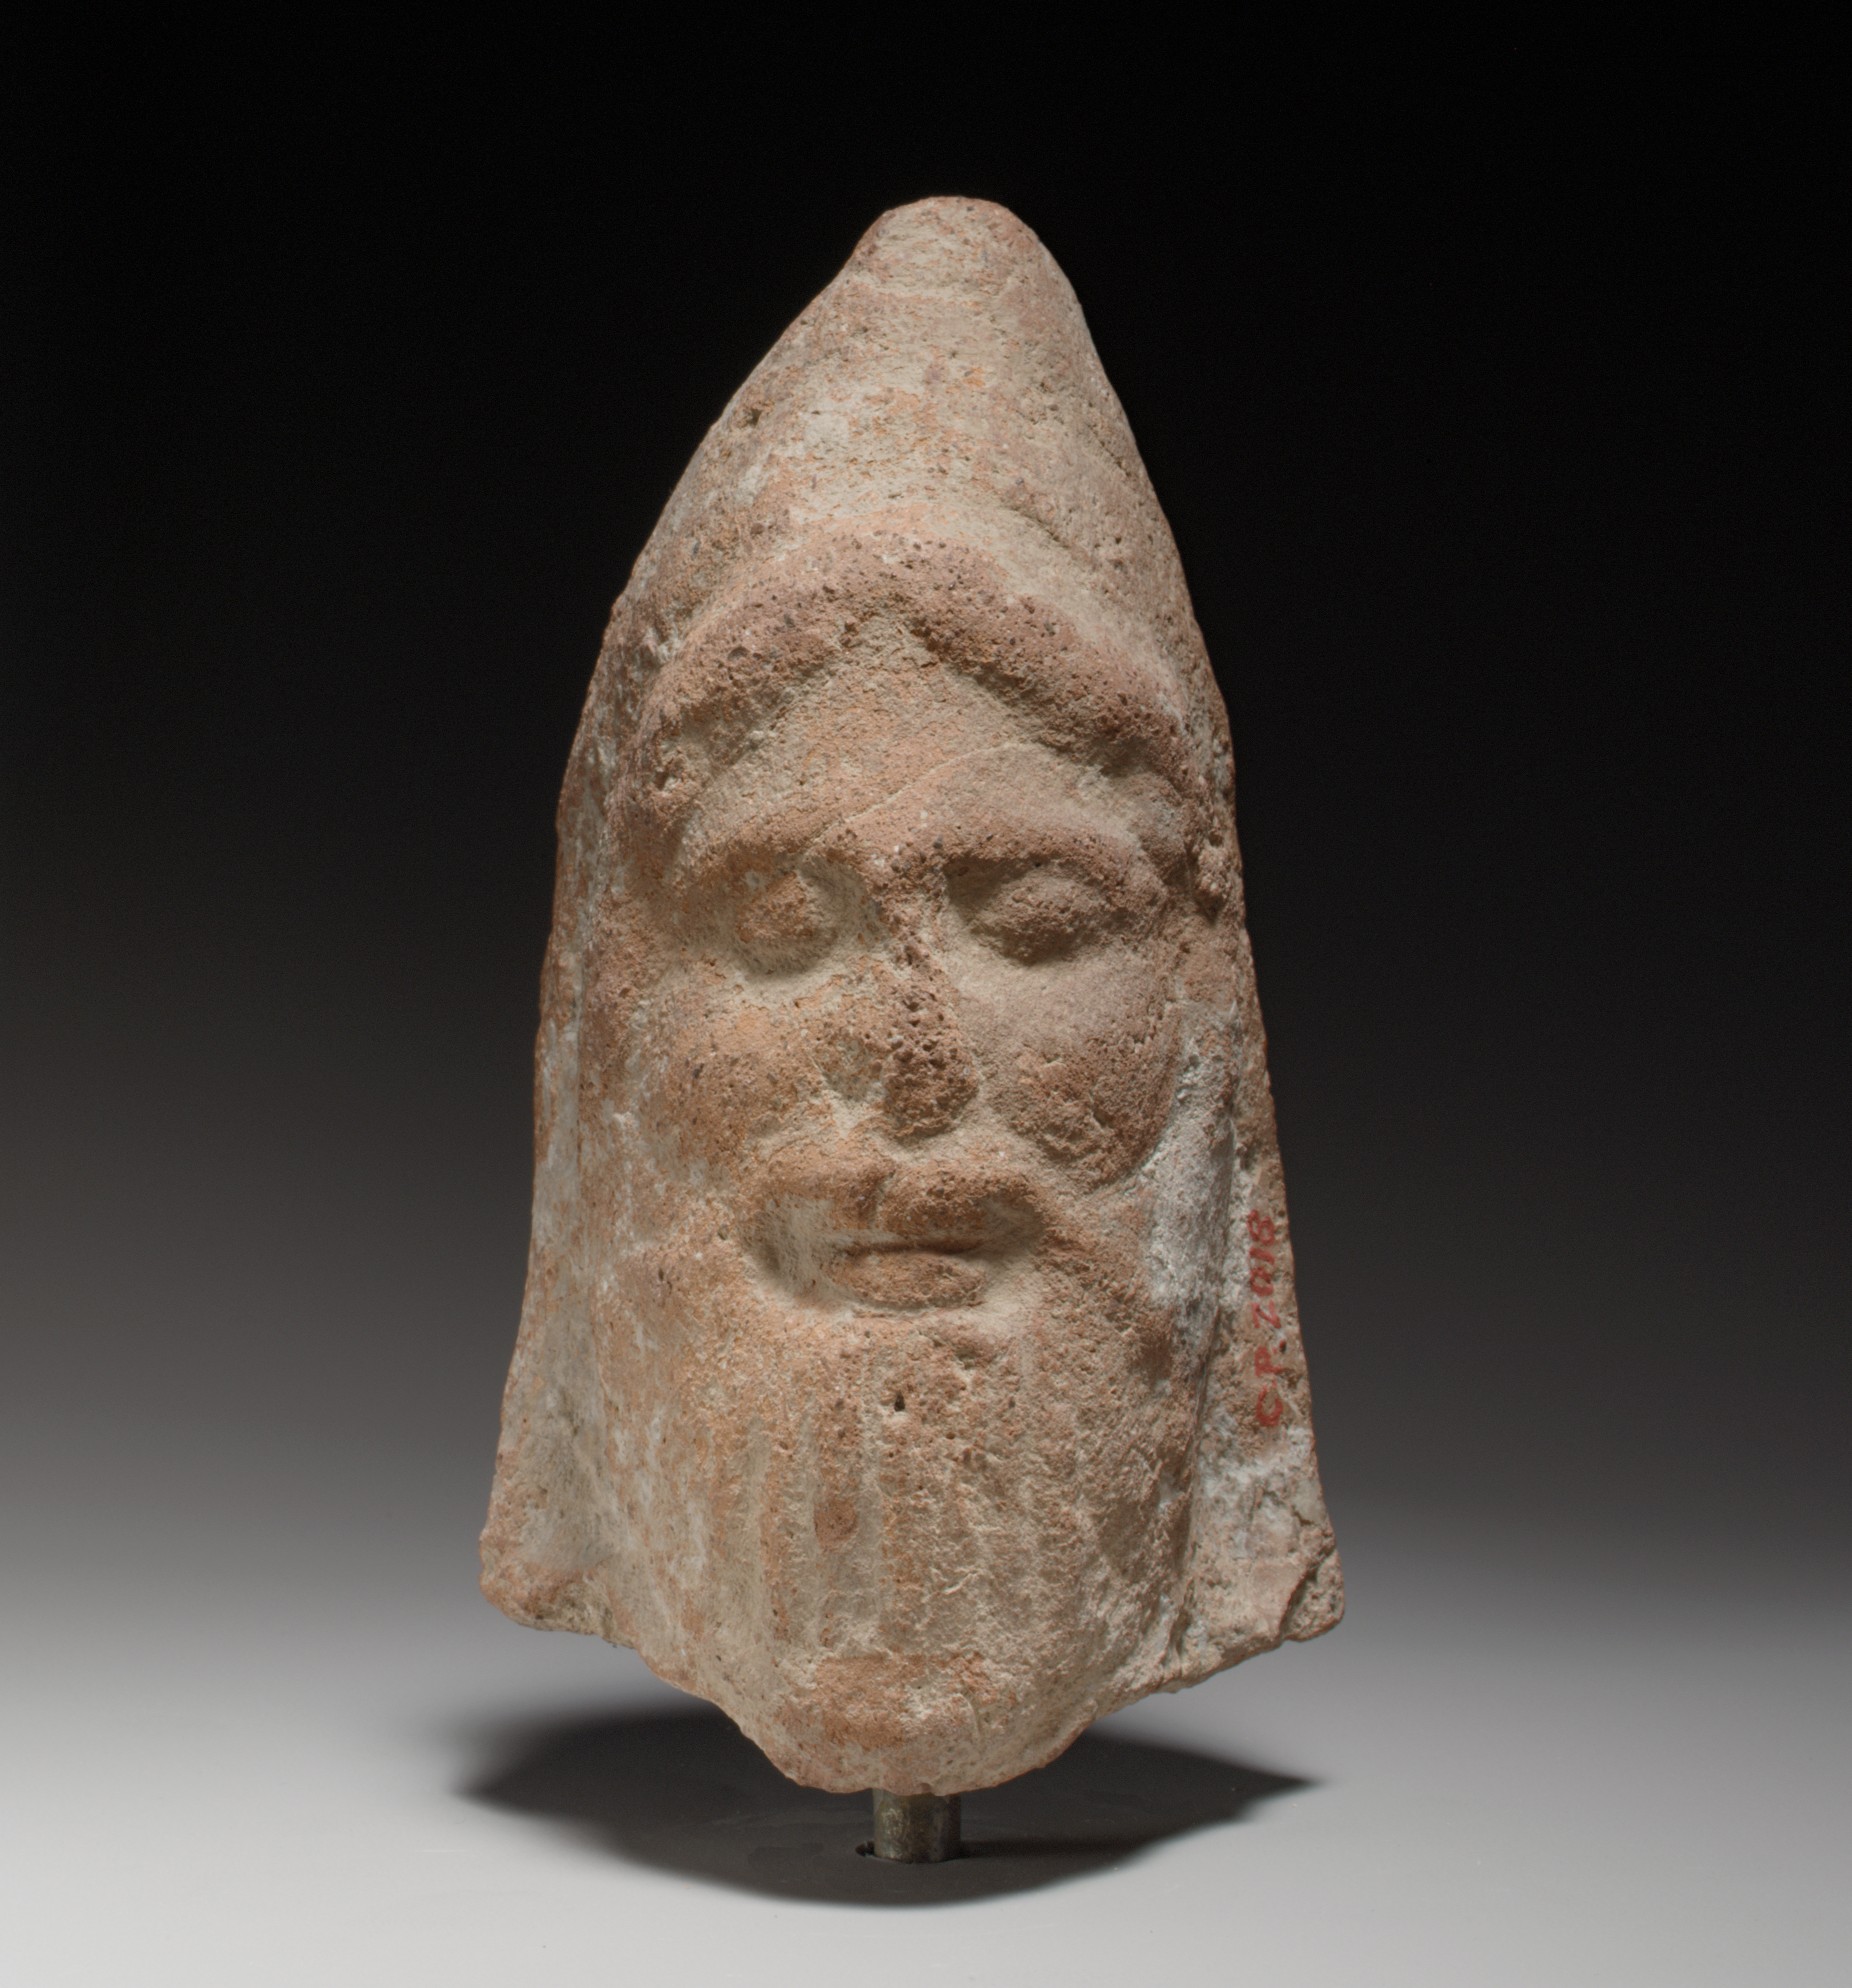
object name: head of a male votary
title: Head of a deity (Melqart?)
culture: cypriot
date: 500-401 BCE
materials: terracotta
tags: heads,men